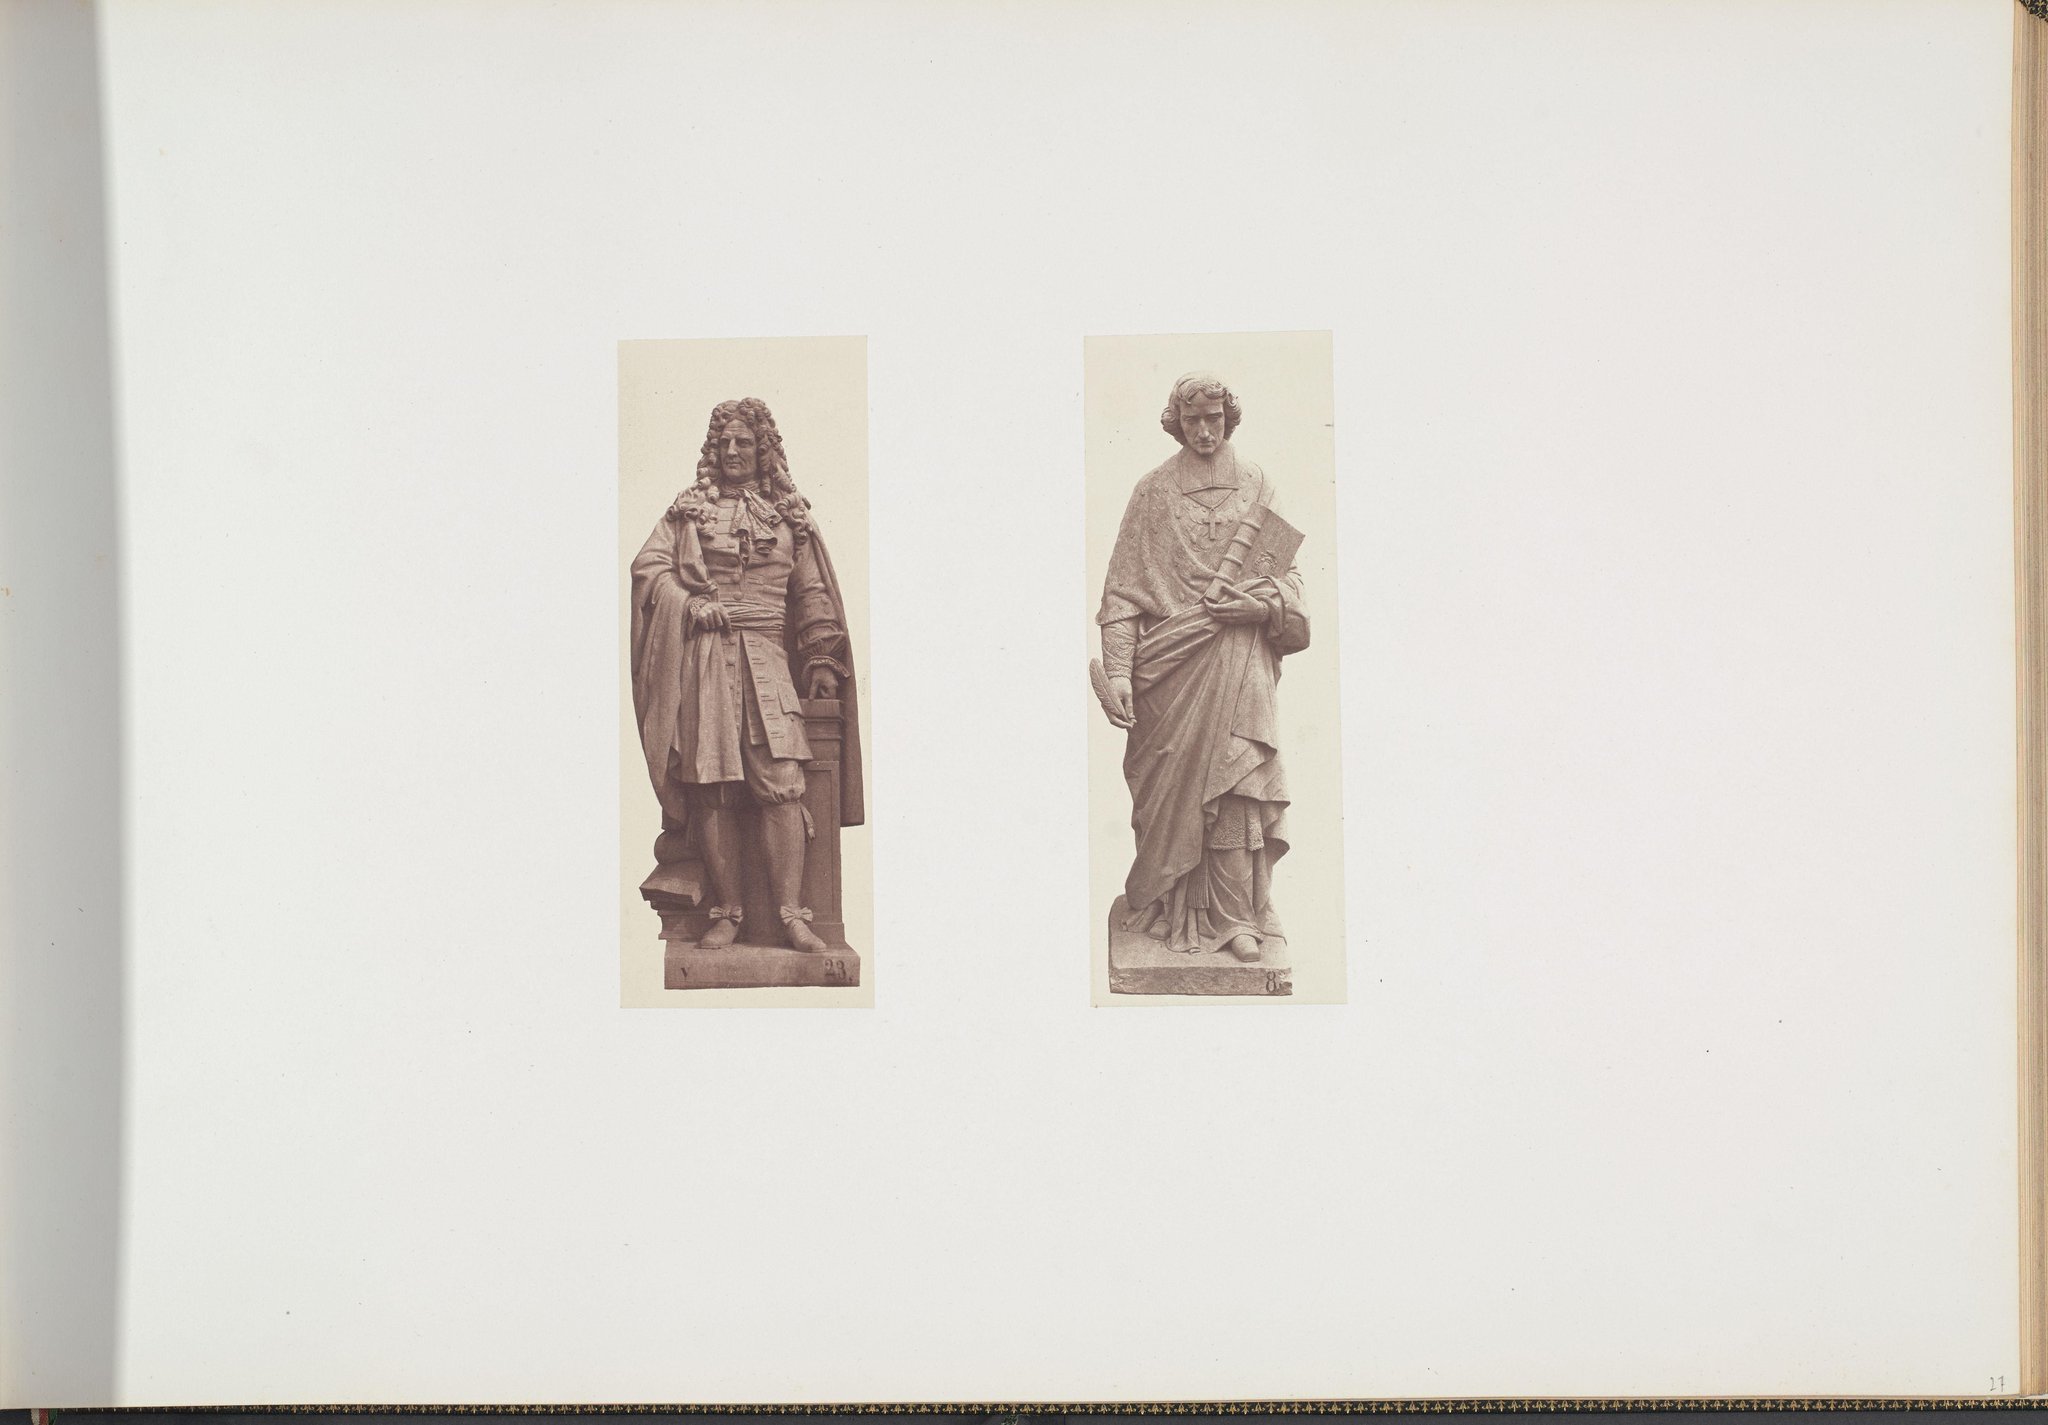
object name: album leaf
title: Gipsmodellen voor beeldhouwwerken op het Palais du Louvre: links "Boileau" door Gabriel Bernard Seurre en rechts "Fénelon" door Jean Bonnassieux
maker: édouard denis baldus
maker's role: fotograaf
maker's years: 1813-1889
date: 1855-1857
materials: paper, photographic support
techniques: salted paper print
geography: paris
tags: piece of sculpture, reproduction of a piece of sculpture, permanent exhibition, museum, paris, tuileries palace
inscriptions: number: ‘V 23 en 8’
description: Onderdeel van Réunion des Tuileries au Louvre 1852-1857, album 1.